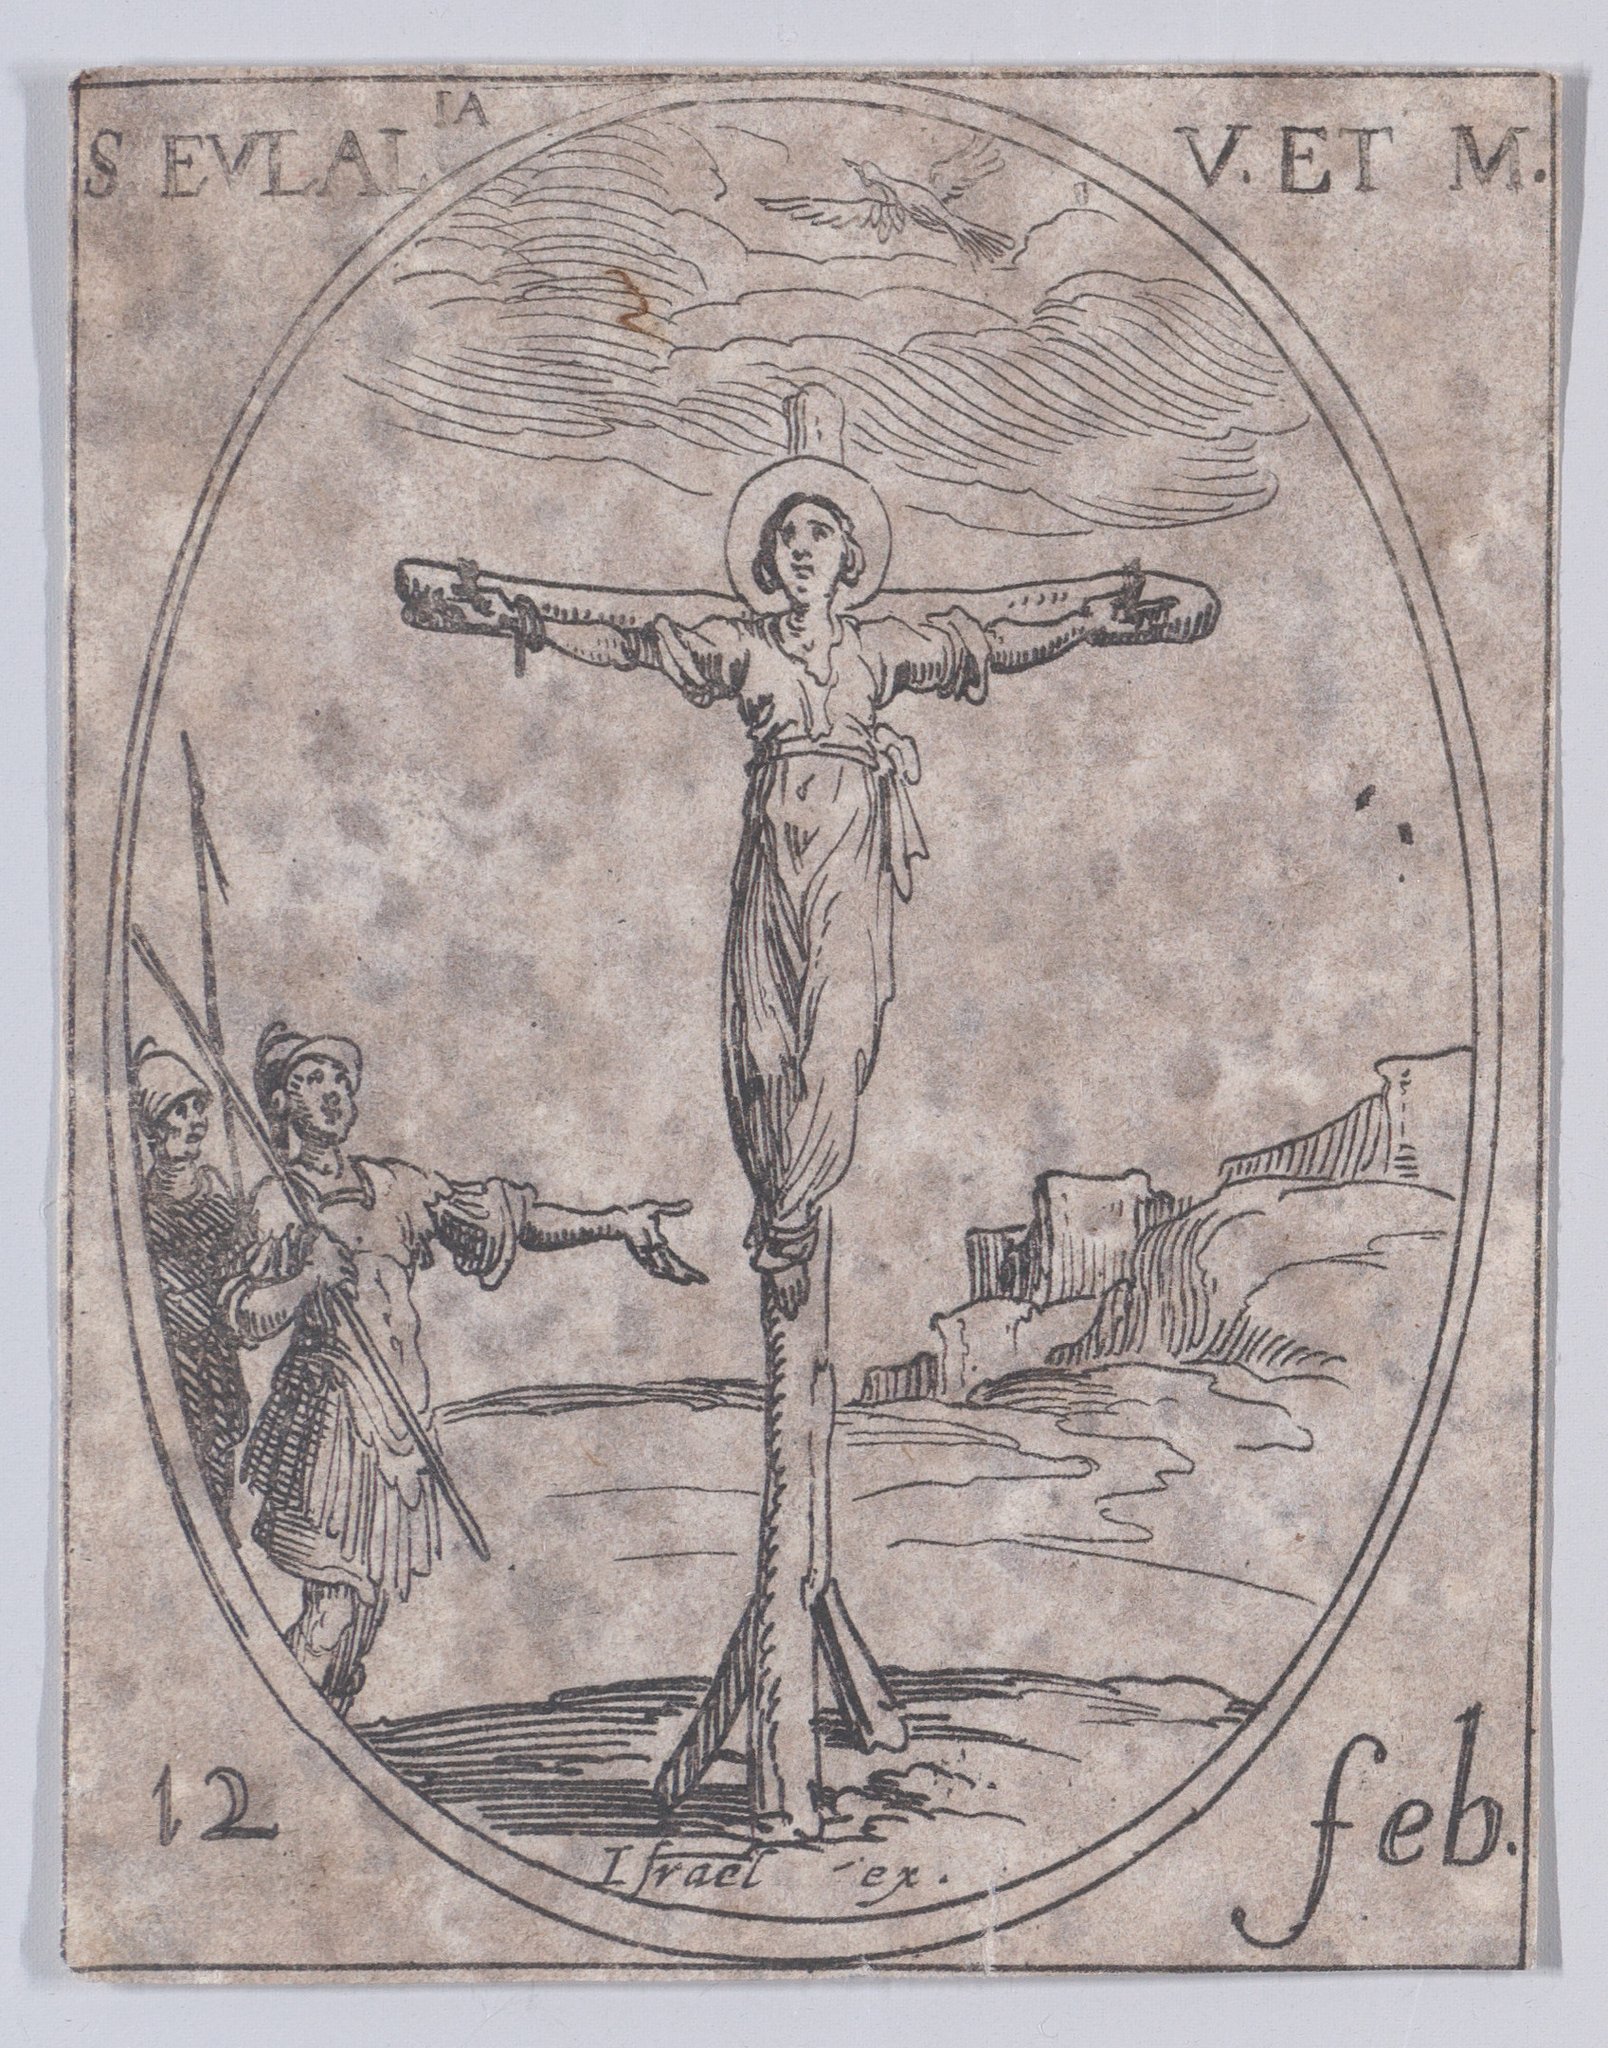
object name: print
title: Ste. Eulalie, vierge et martyre (St. Eulalia, Virgin and Martyr), February 12th, from "Les Images De Tous Les Saincts et Saintes de L'Année" (Images of All of the Saints and Religious Events of the Year)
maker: jacques callot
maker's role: artist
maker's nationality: french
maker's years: 1592-1635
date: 1636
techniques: etching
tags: women,crucifixion,saints